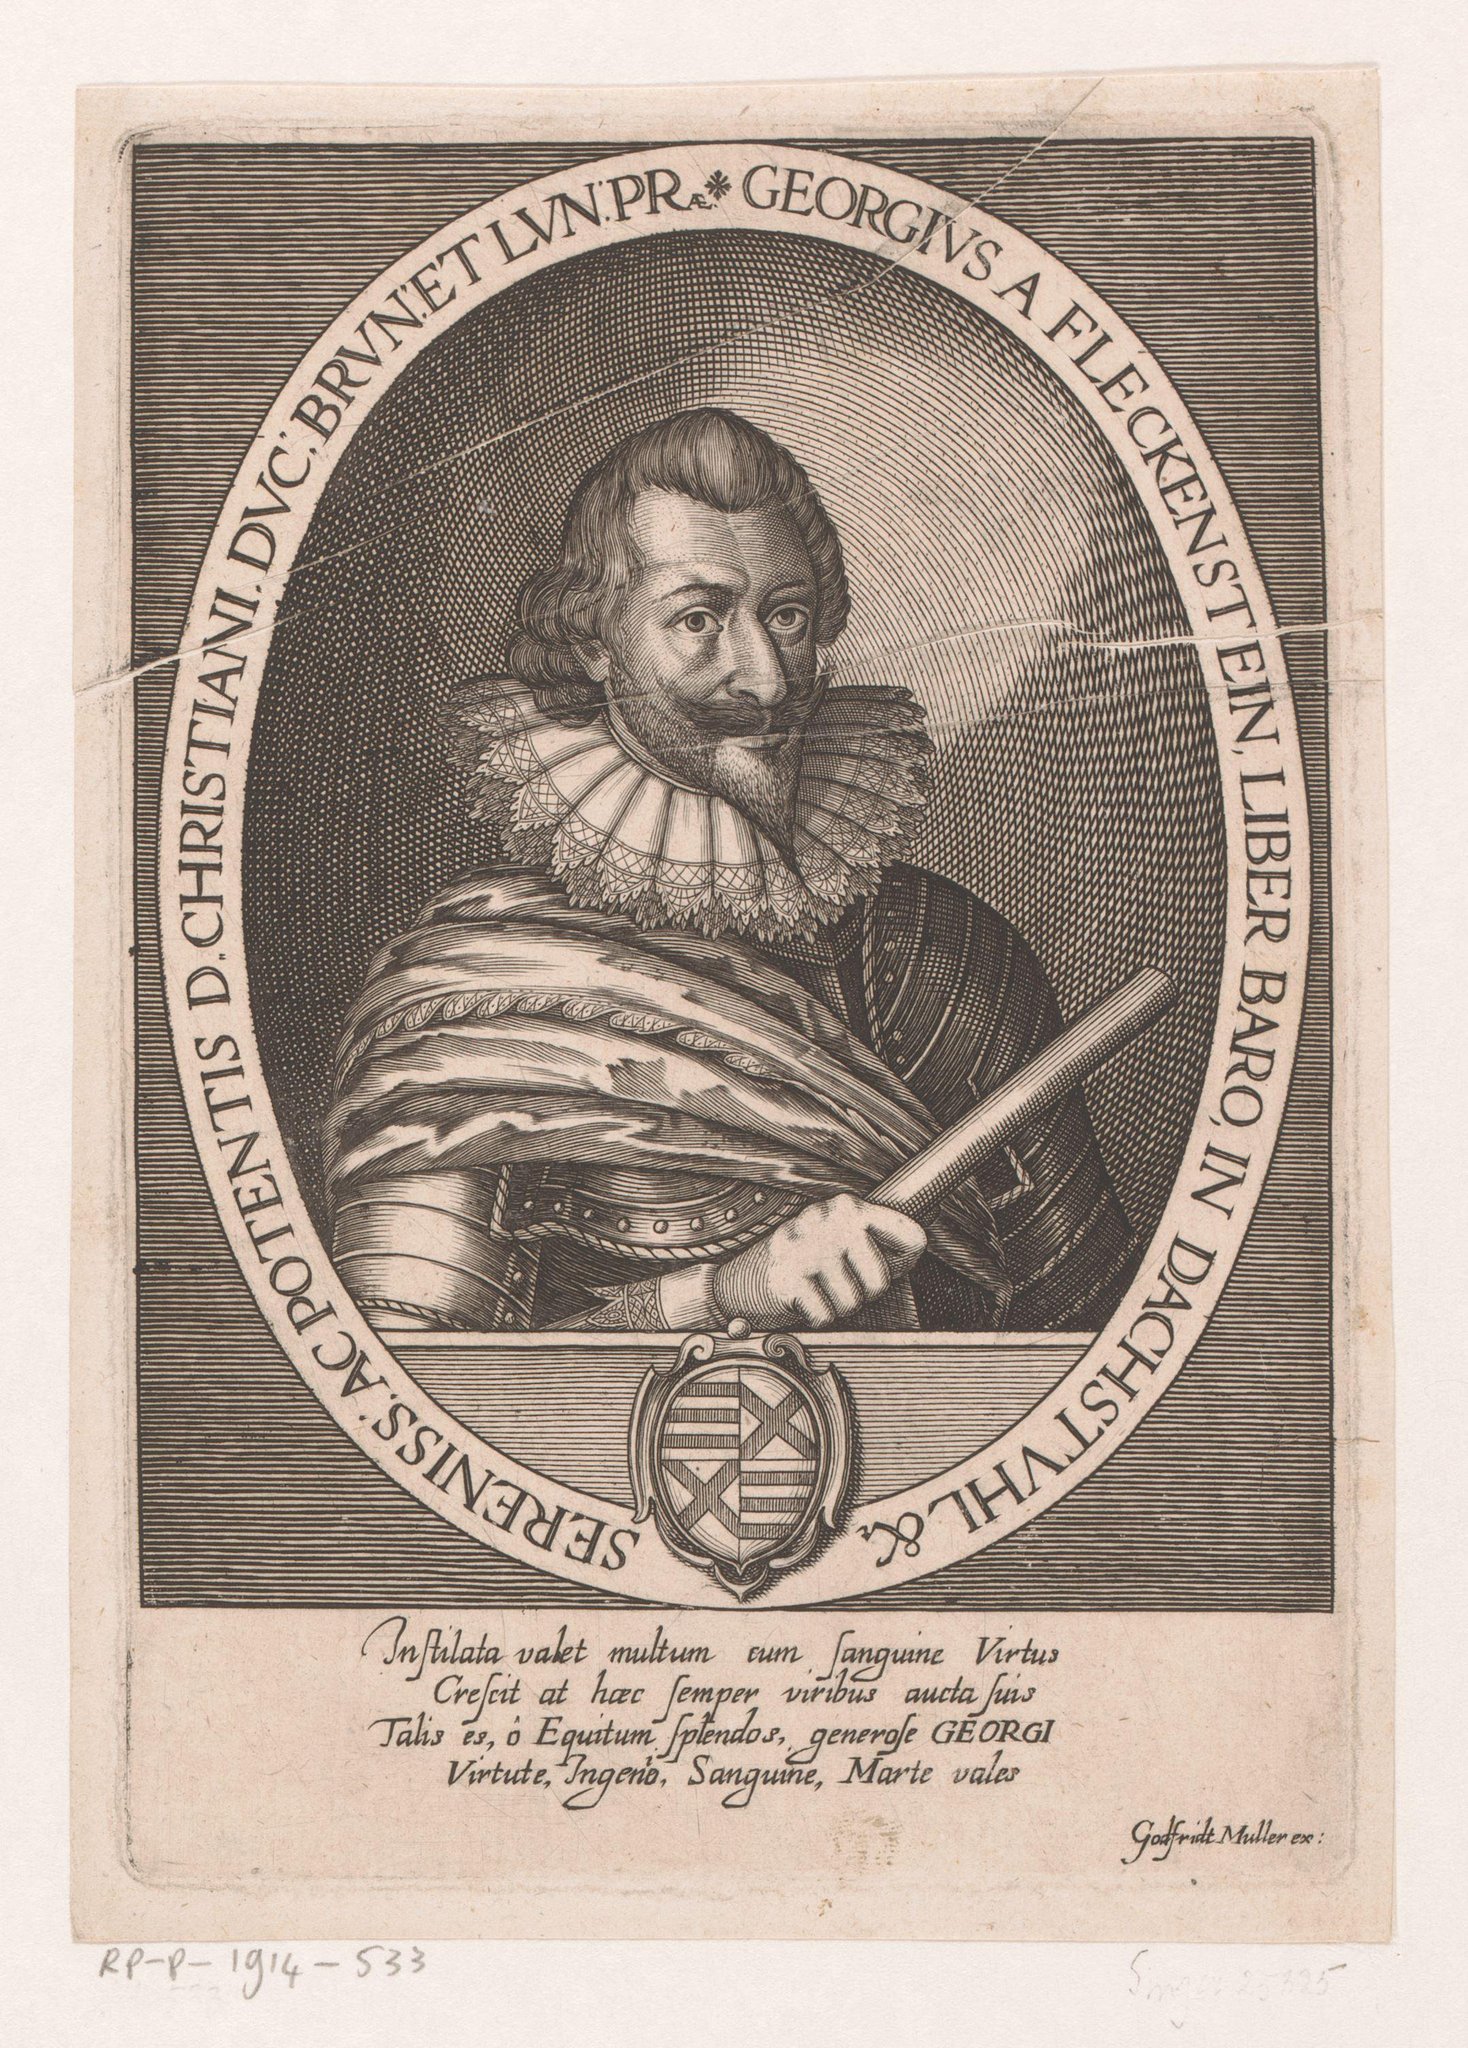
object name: print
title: Portret van Georg II von Fleckenstein-Dagstuhl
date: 1620-1656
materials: paper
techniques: engraving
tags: armour, historical persons, baton of general, armorial bearing, heraldry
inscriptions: collector's mark: Lugt 2228